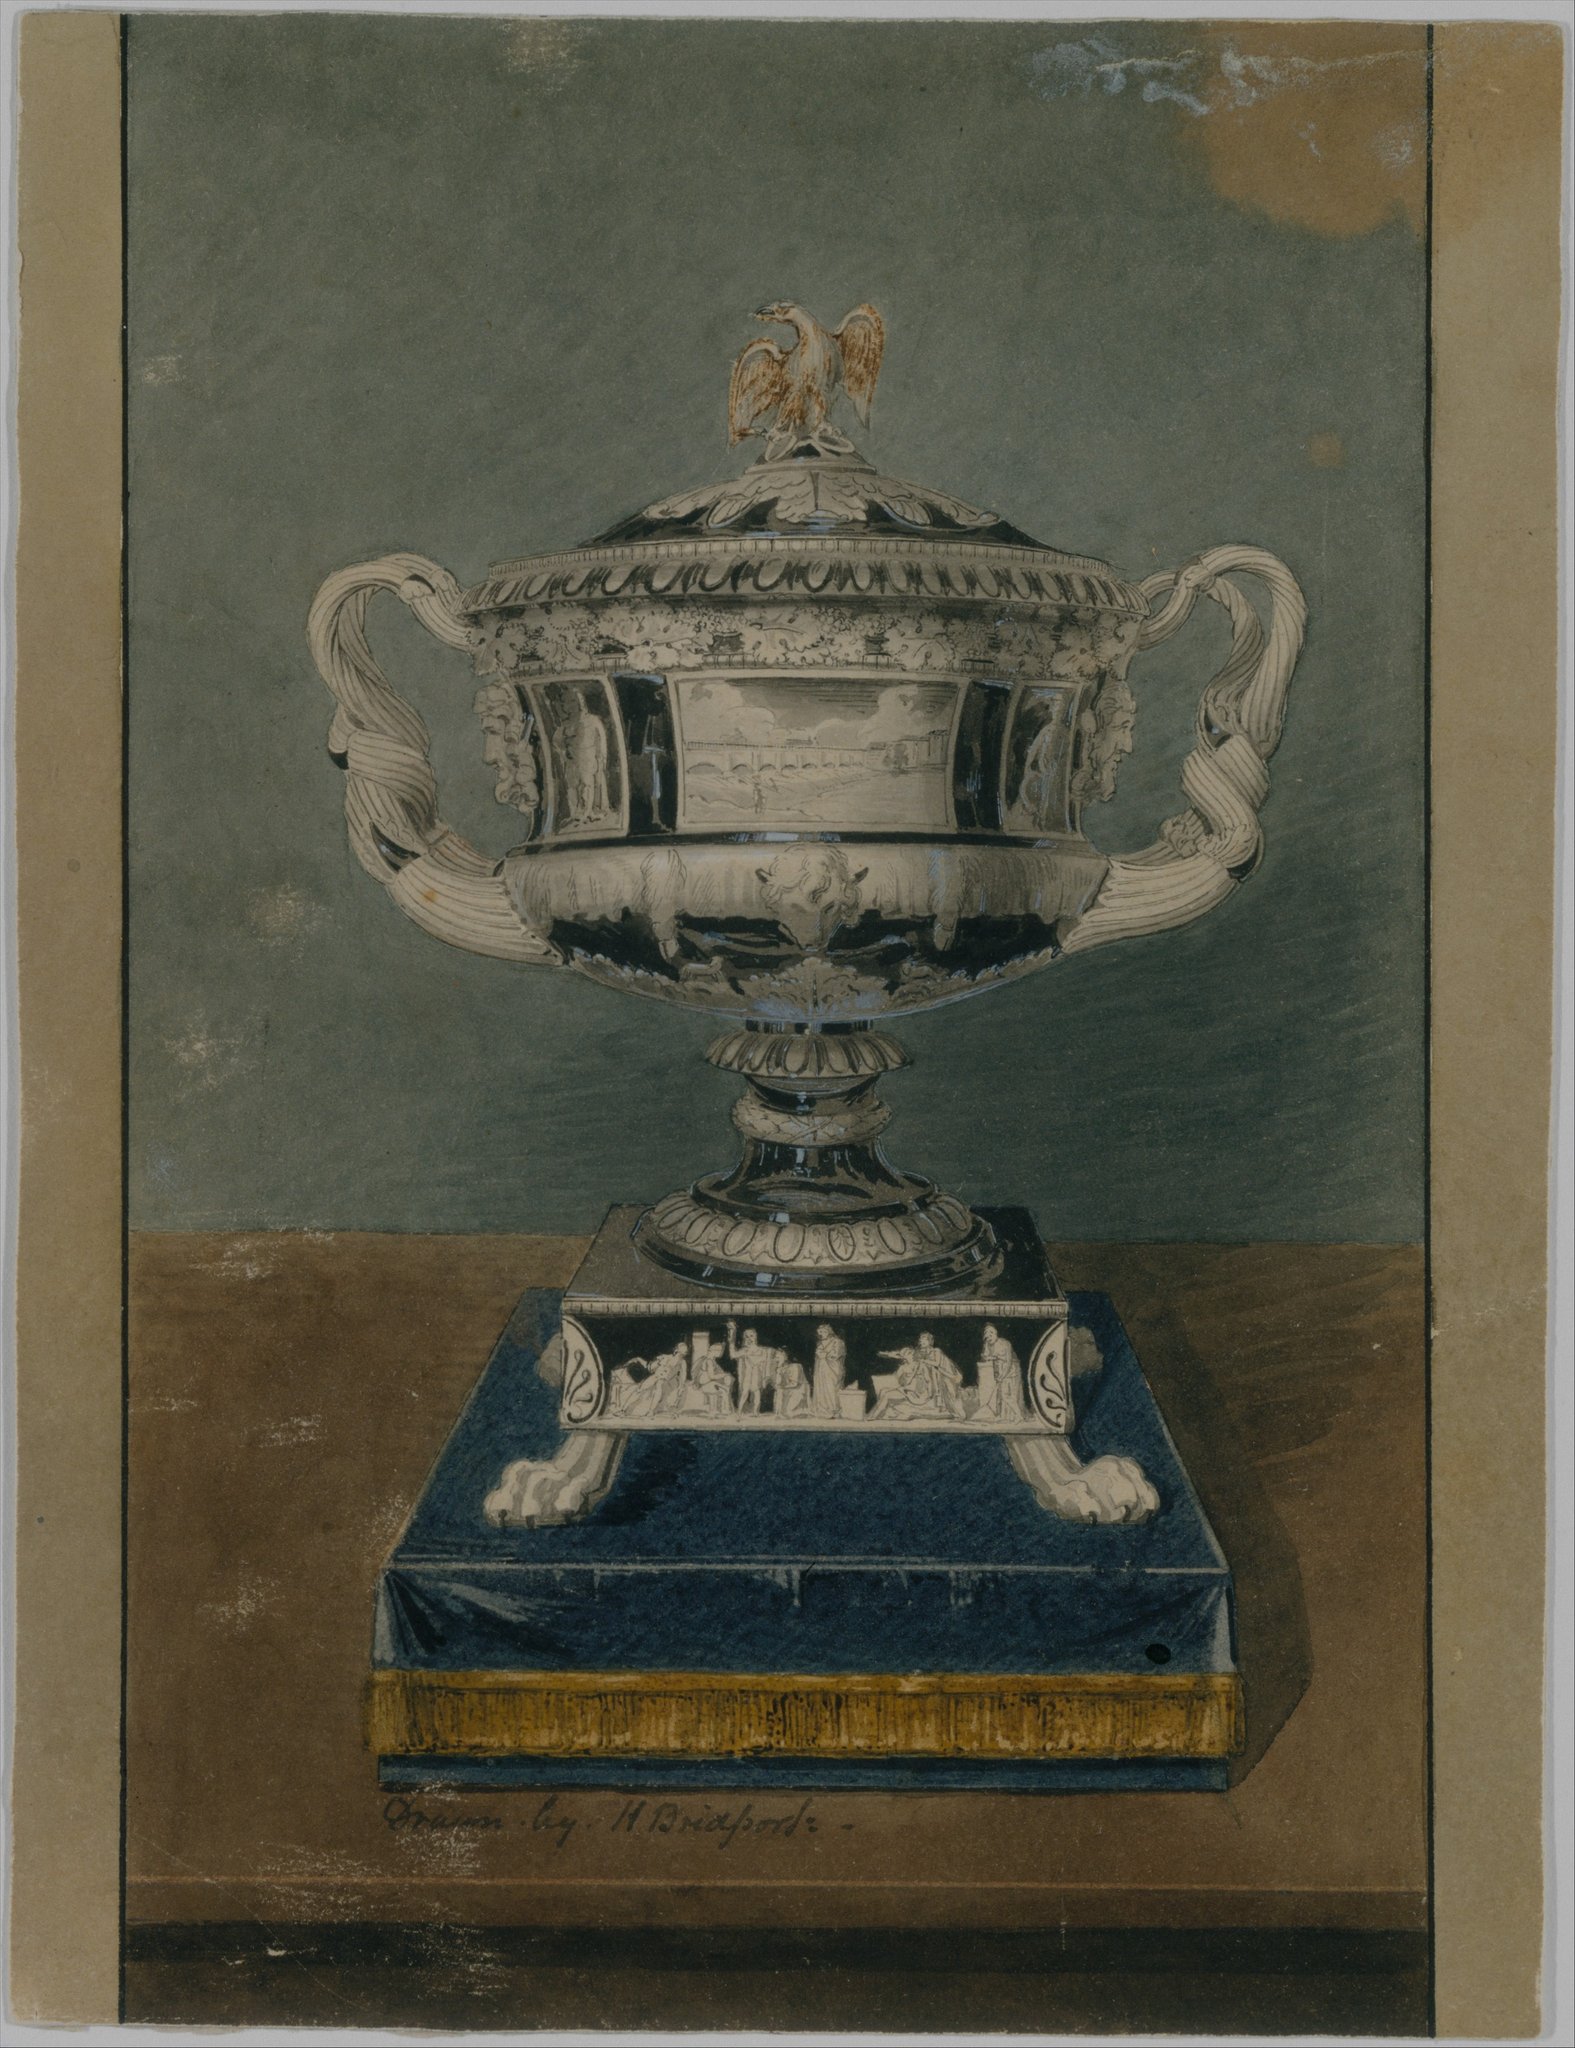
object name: drawing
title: Drawing of Clinton Vase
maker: thomas fletcher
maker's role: designer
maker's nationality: american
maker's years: 1787-1866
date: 1824-1825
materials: ink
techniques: brush, pen, wash